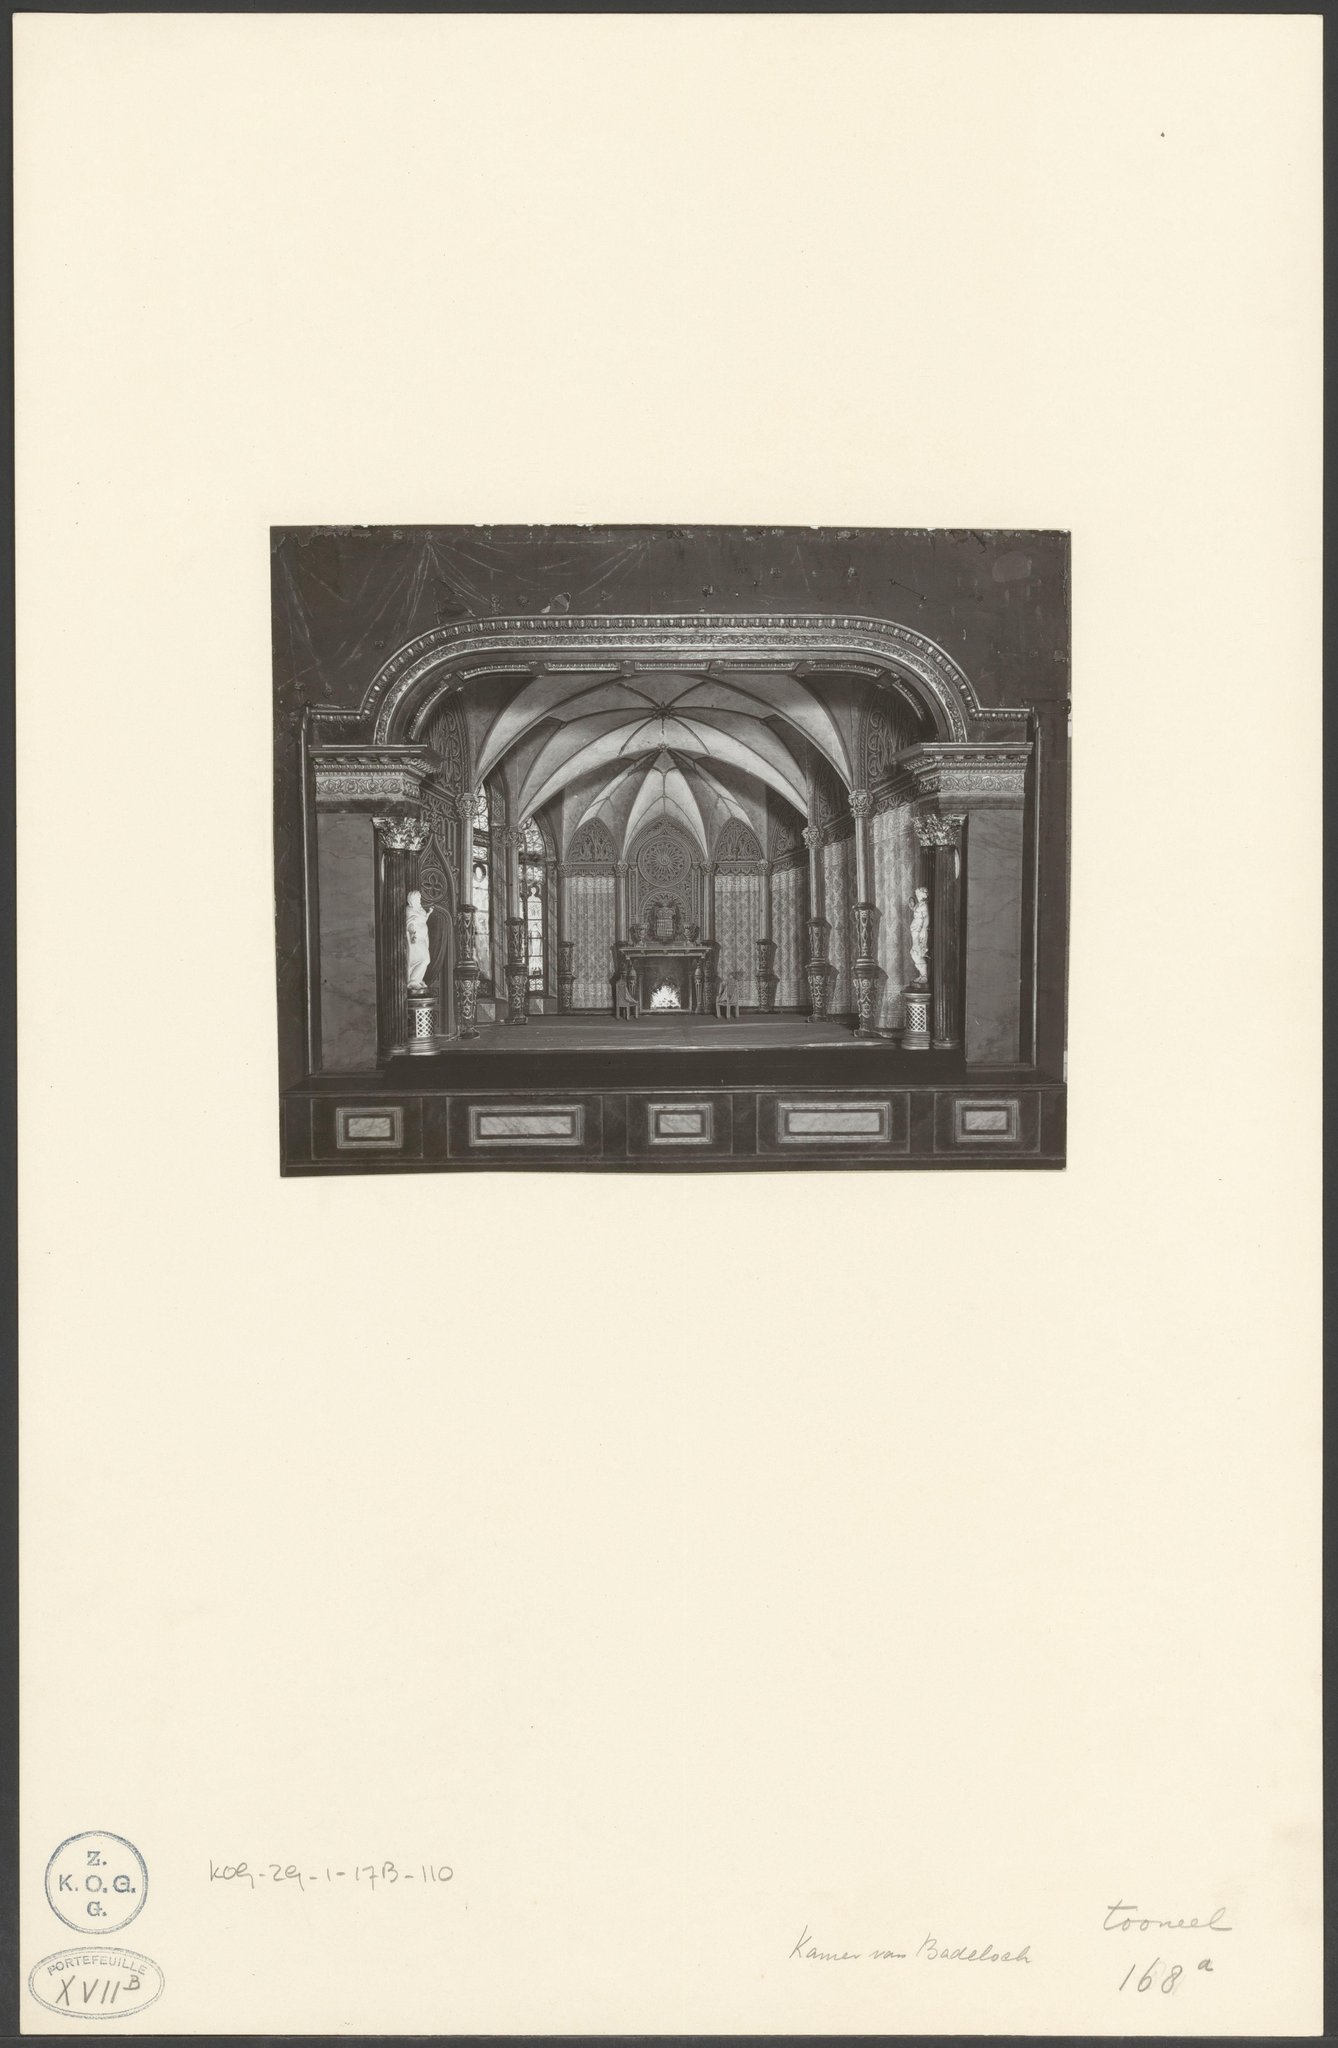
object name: photograph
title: Toneeldecor: Kamer van Badeloch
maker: Anonymous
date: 1880-1949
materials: paper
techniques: gelatin silver print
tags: theatre, theatrical performance, stage design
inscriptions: collector's mark: Lugt 1641, stamp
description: Toneeldecor van de Kamer van Badeloch uit de Gijsbrecht van Amstel. Decor voor de Schouwburg op het Leidseplein. Onderwerpsrubrieken binnen de Atlas Zeden en Gewoonten: Schoone kunsten, Tooneel, Decors voor de Schouwburg.